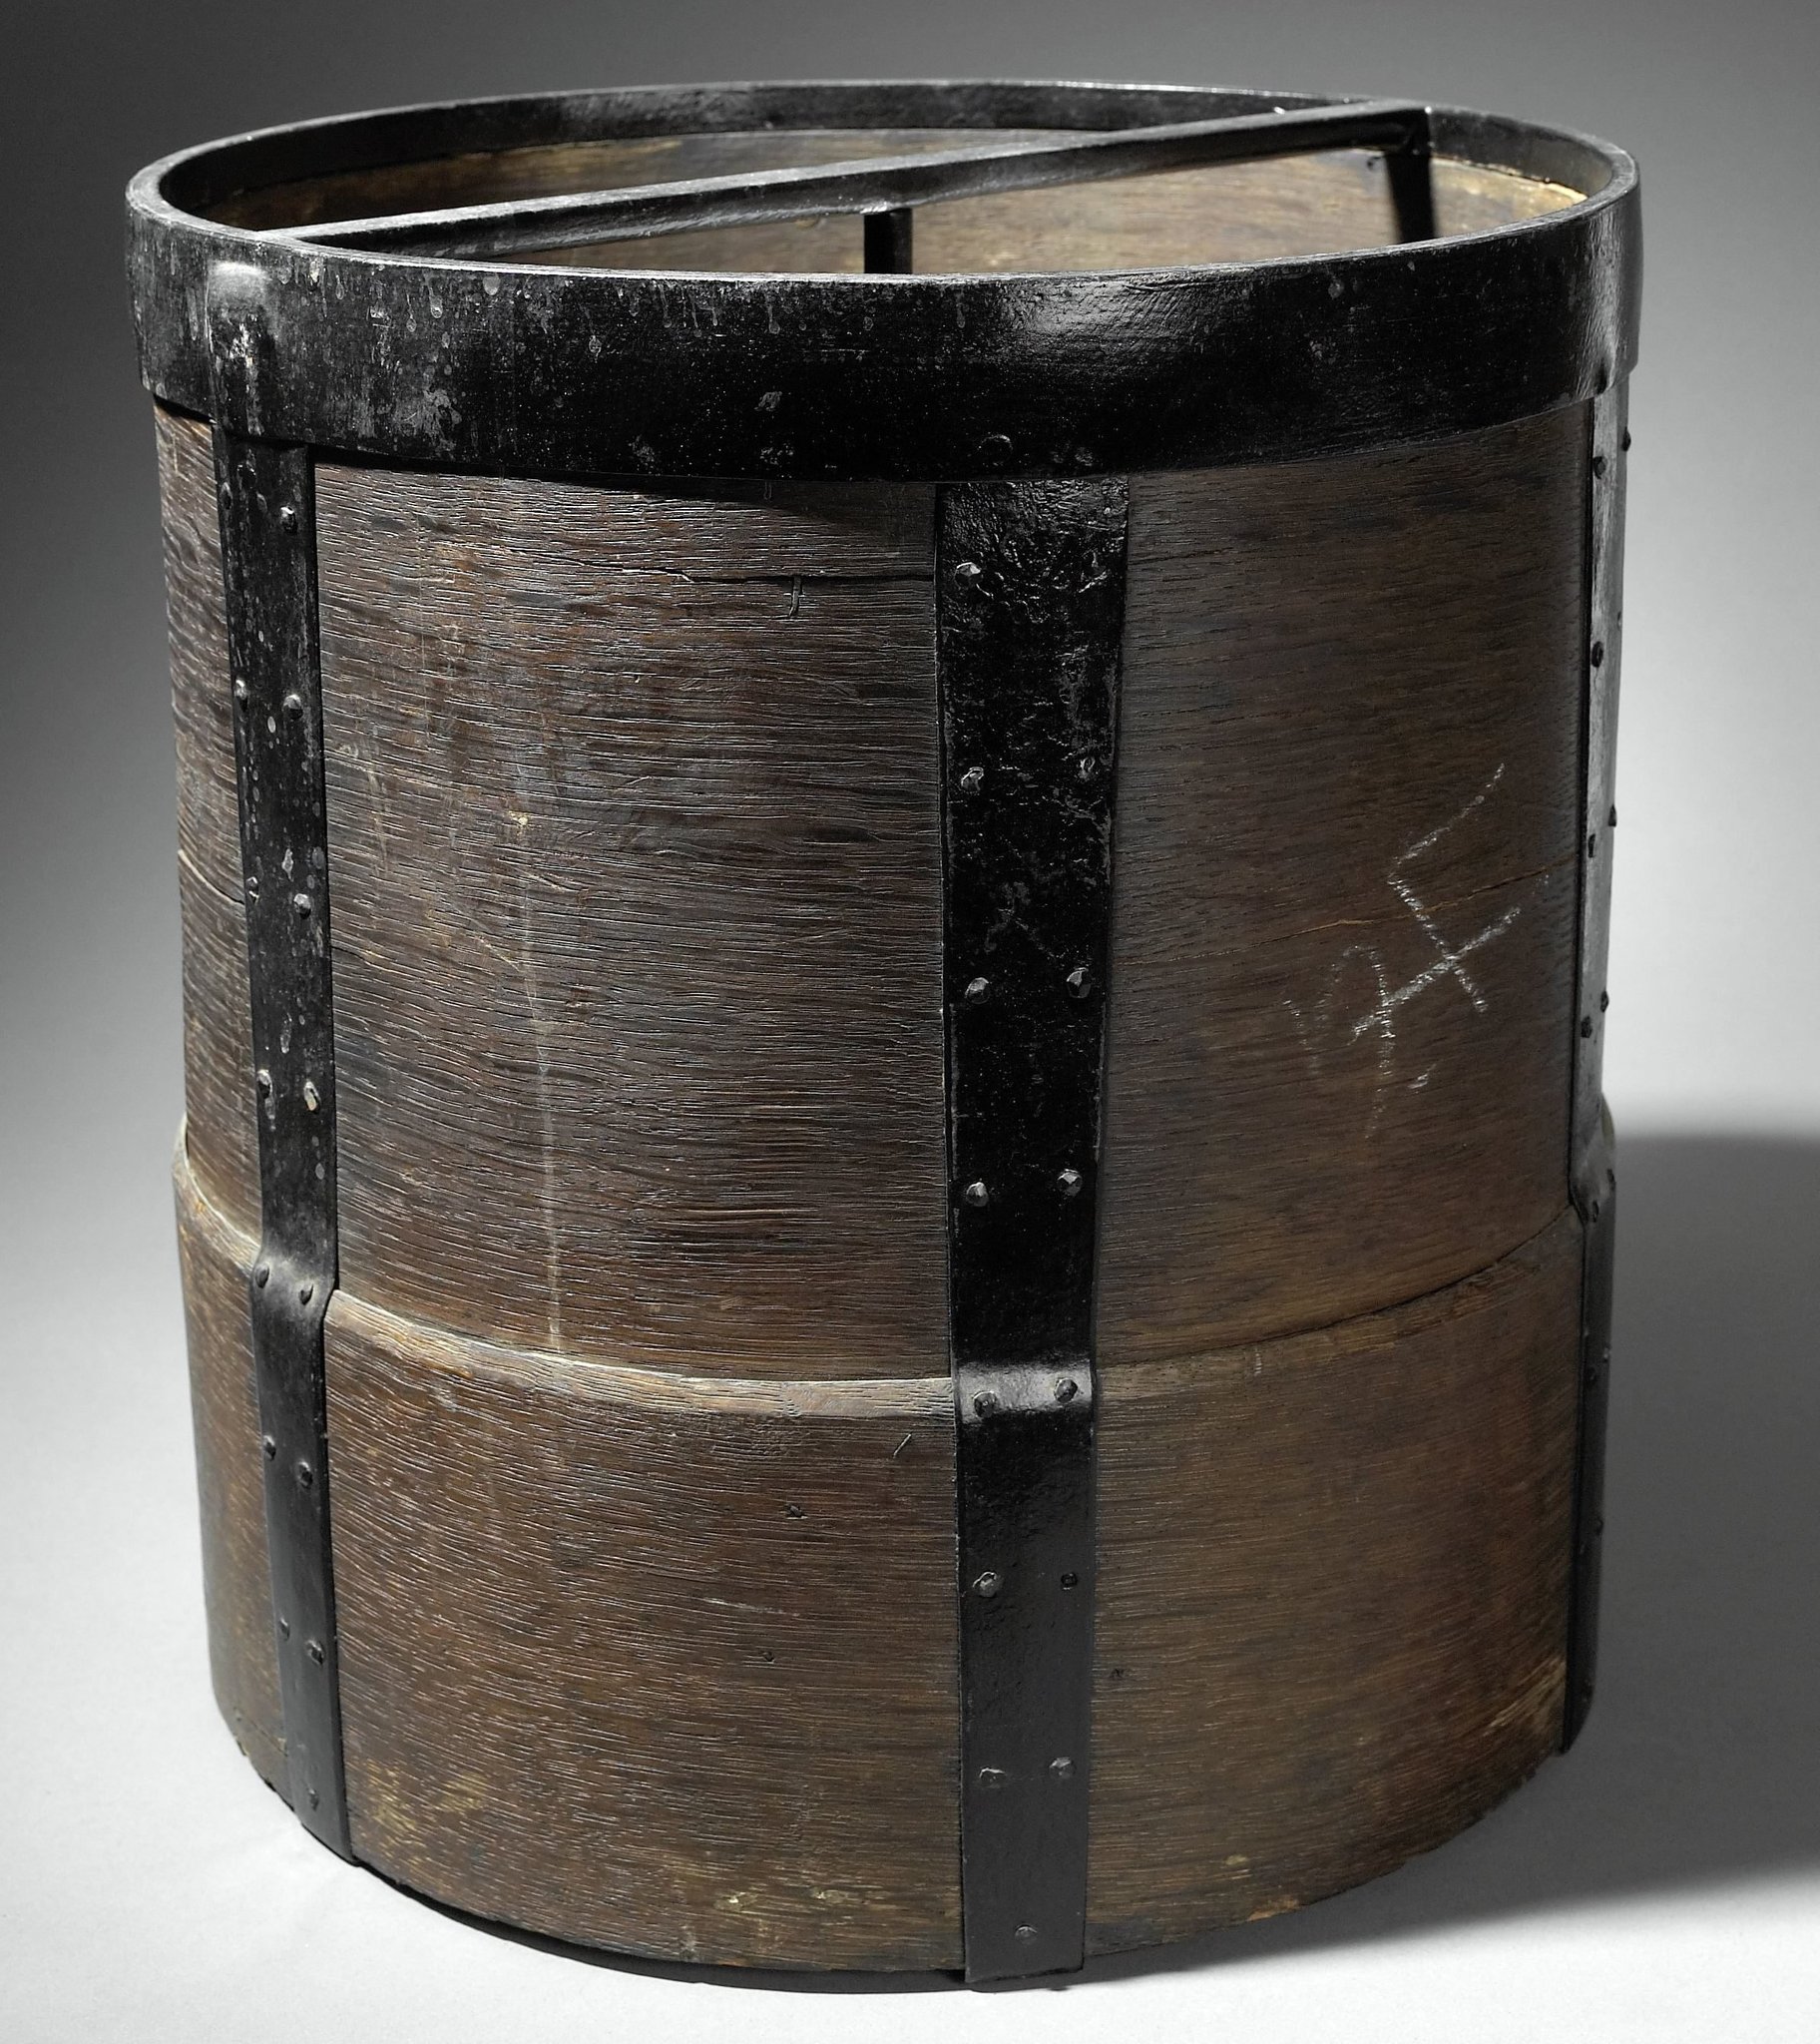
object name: inhoudsmaat droge waren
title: Inhoudsmaat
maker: Anonymous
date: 1820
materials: iron, wood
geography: netherlands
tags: netherlands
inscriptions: number: ‘35’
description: Spanen inhoudsmaat met brug en stijl, meetrand en beslag van ijzer en houten justeerblok. Aan de buitenzijde (onder) een 12 cm brede houten versterkingsband. V.z.v. etiket.